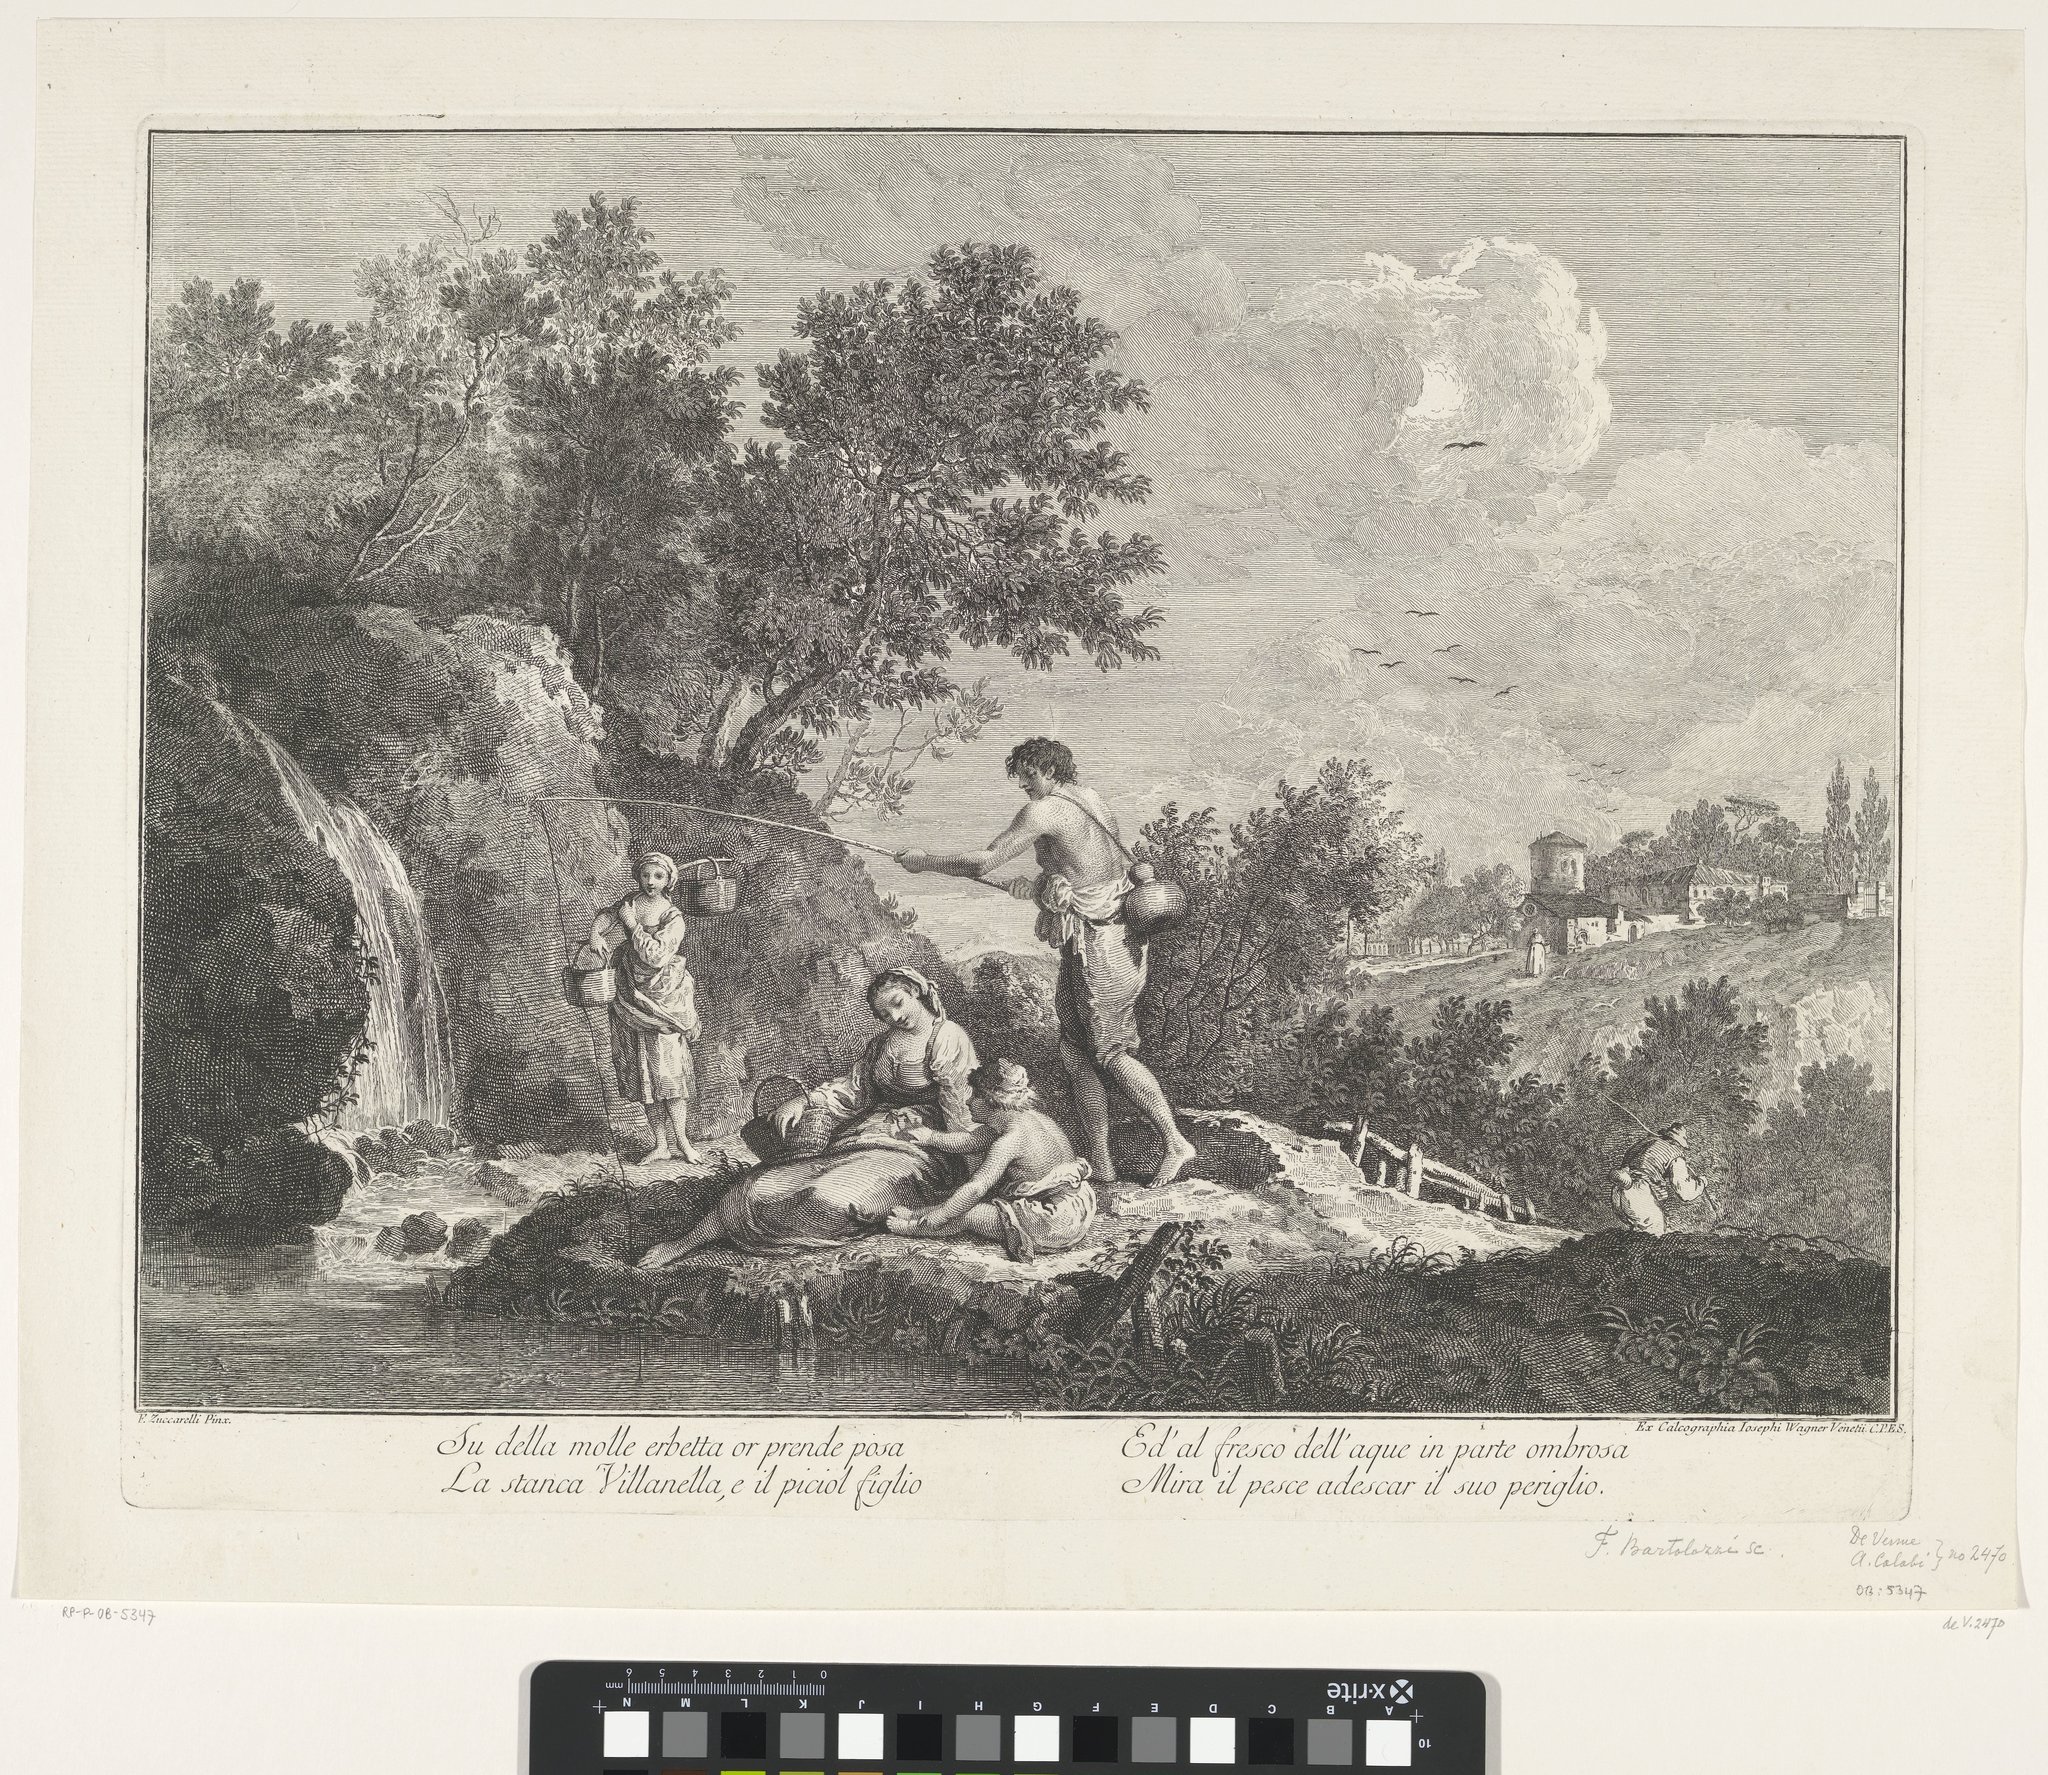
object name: print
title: Landschappen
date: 1760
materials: paper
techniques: engraving, etching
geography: venice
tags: city-view, and landscape with man-made constructions, herding, herdsman, herdswoman, shepherd, shepherdess, cowherd, etc., waterfall, fishing (sports)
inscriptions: collector's mark: Lugt 240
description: Een landschap met een zittende vrouw met mand en kind, een visser met een vishengel en een vrouw met twee manden bij een waterval.